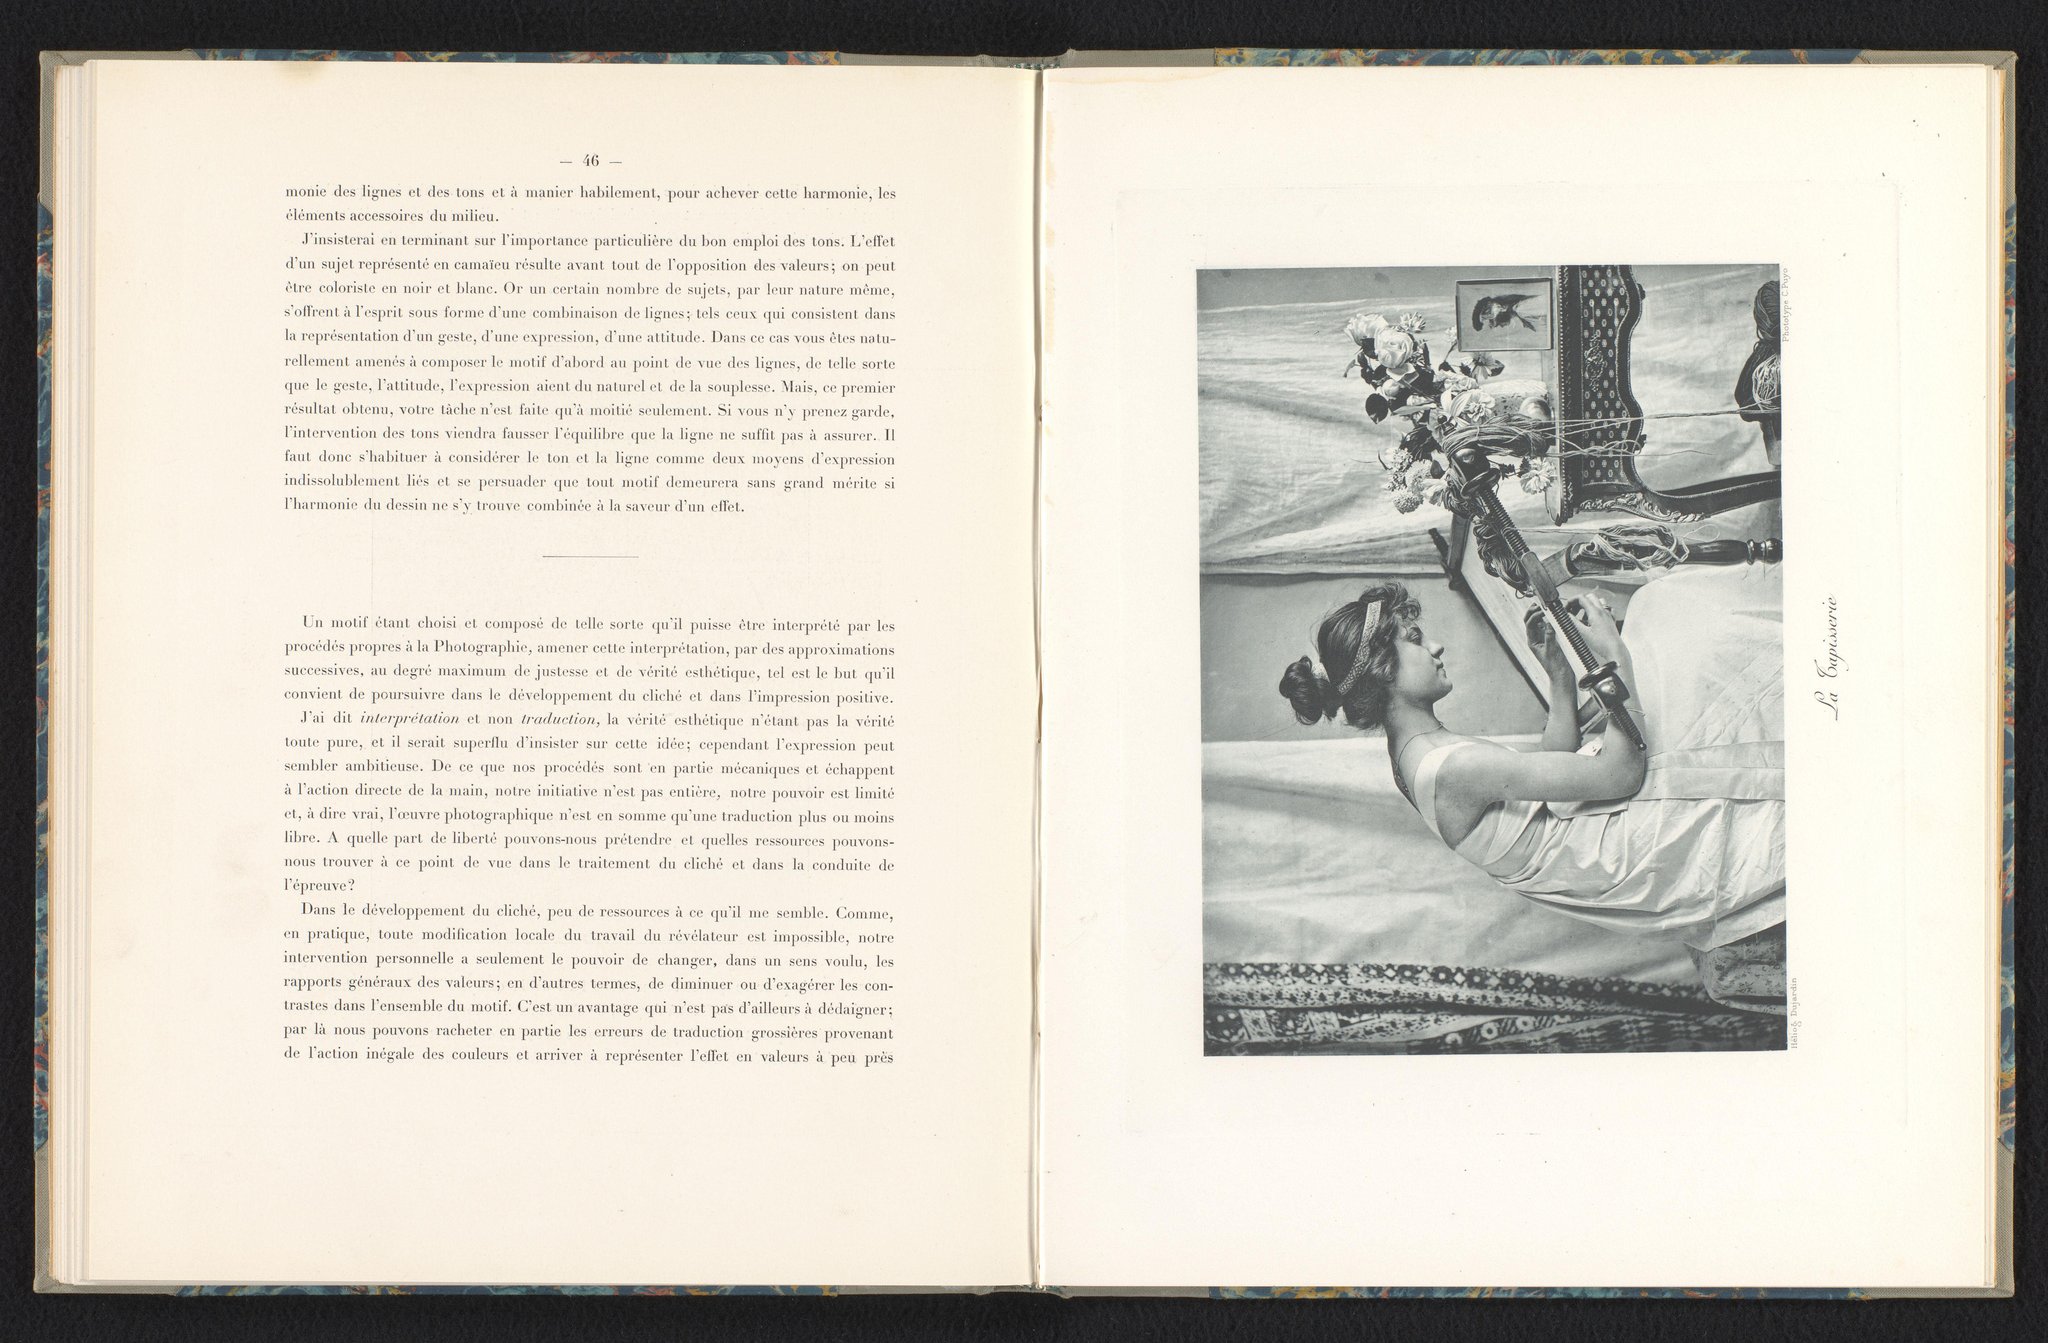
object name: photomechanical print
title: La tapisserie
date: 1891-1896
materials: paper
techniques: photoaquatint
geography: france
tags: adult woman, interior ~ representation of a building, weaving-loom, weaving